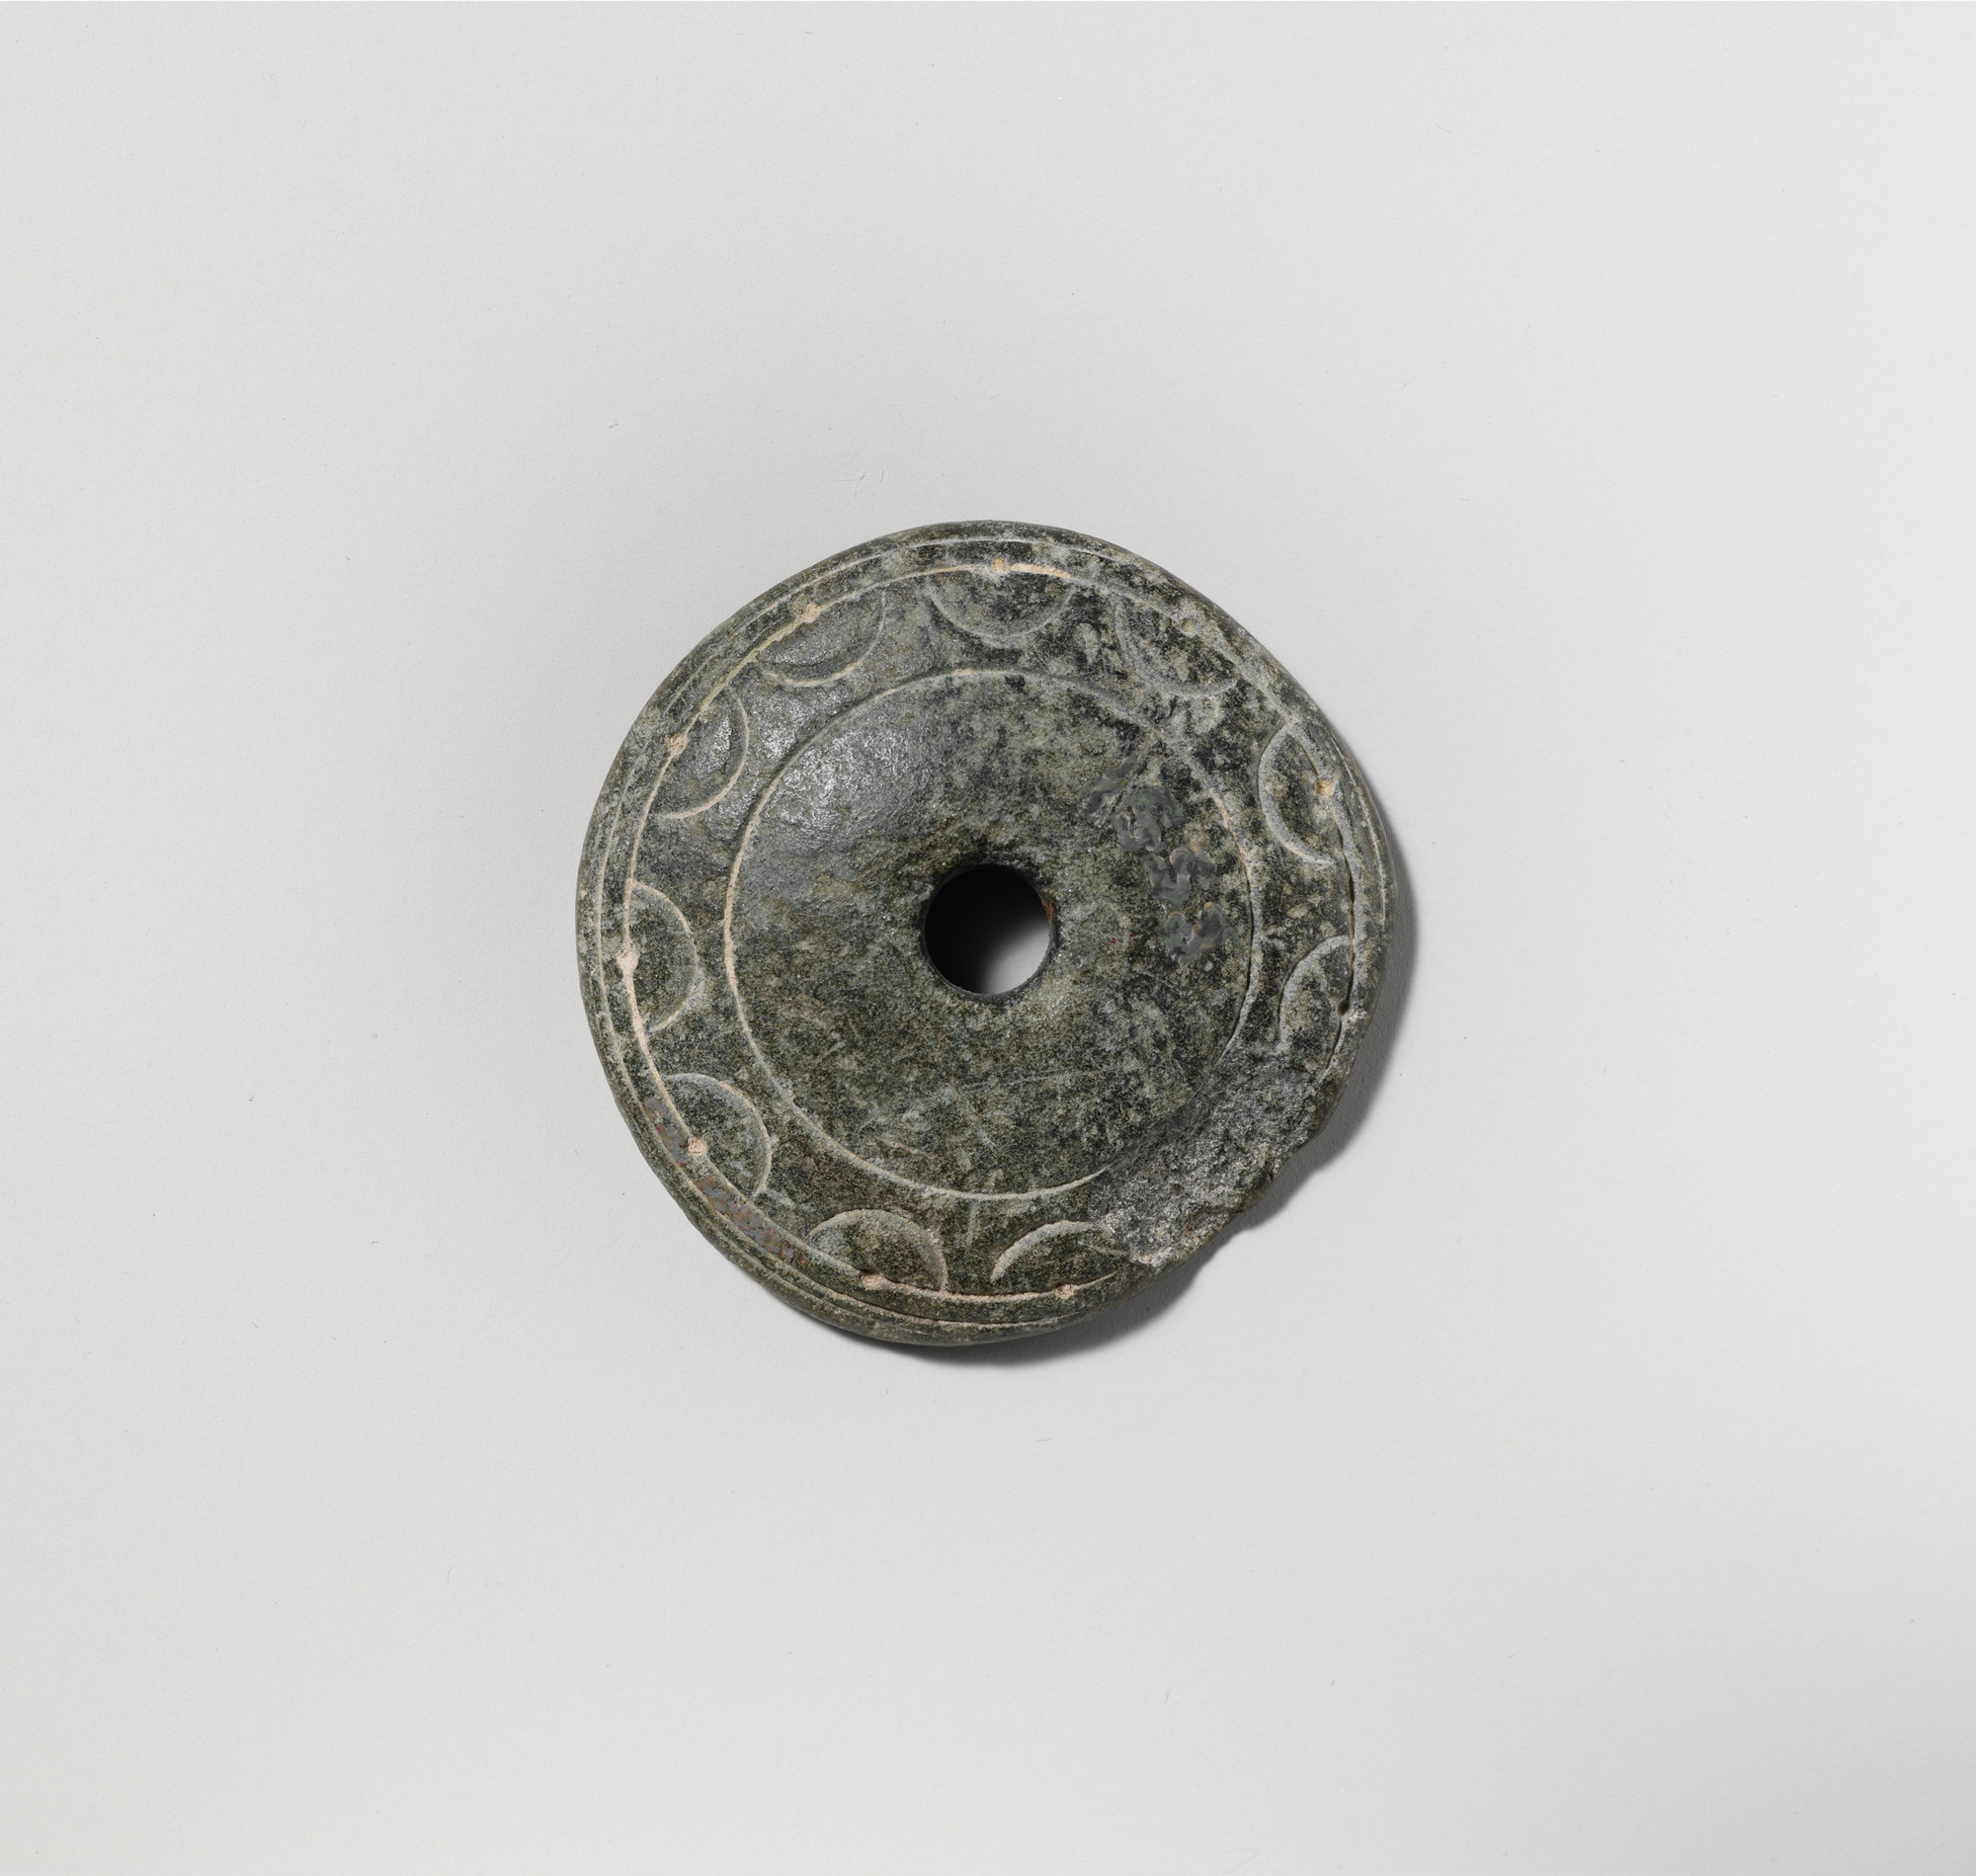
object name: spindle whorl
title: Chlorite spindle whorl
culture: cypriot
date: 1200-1050 BCE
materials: mineral